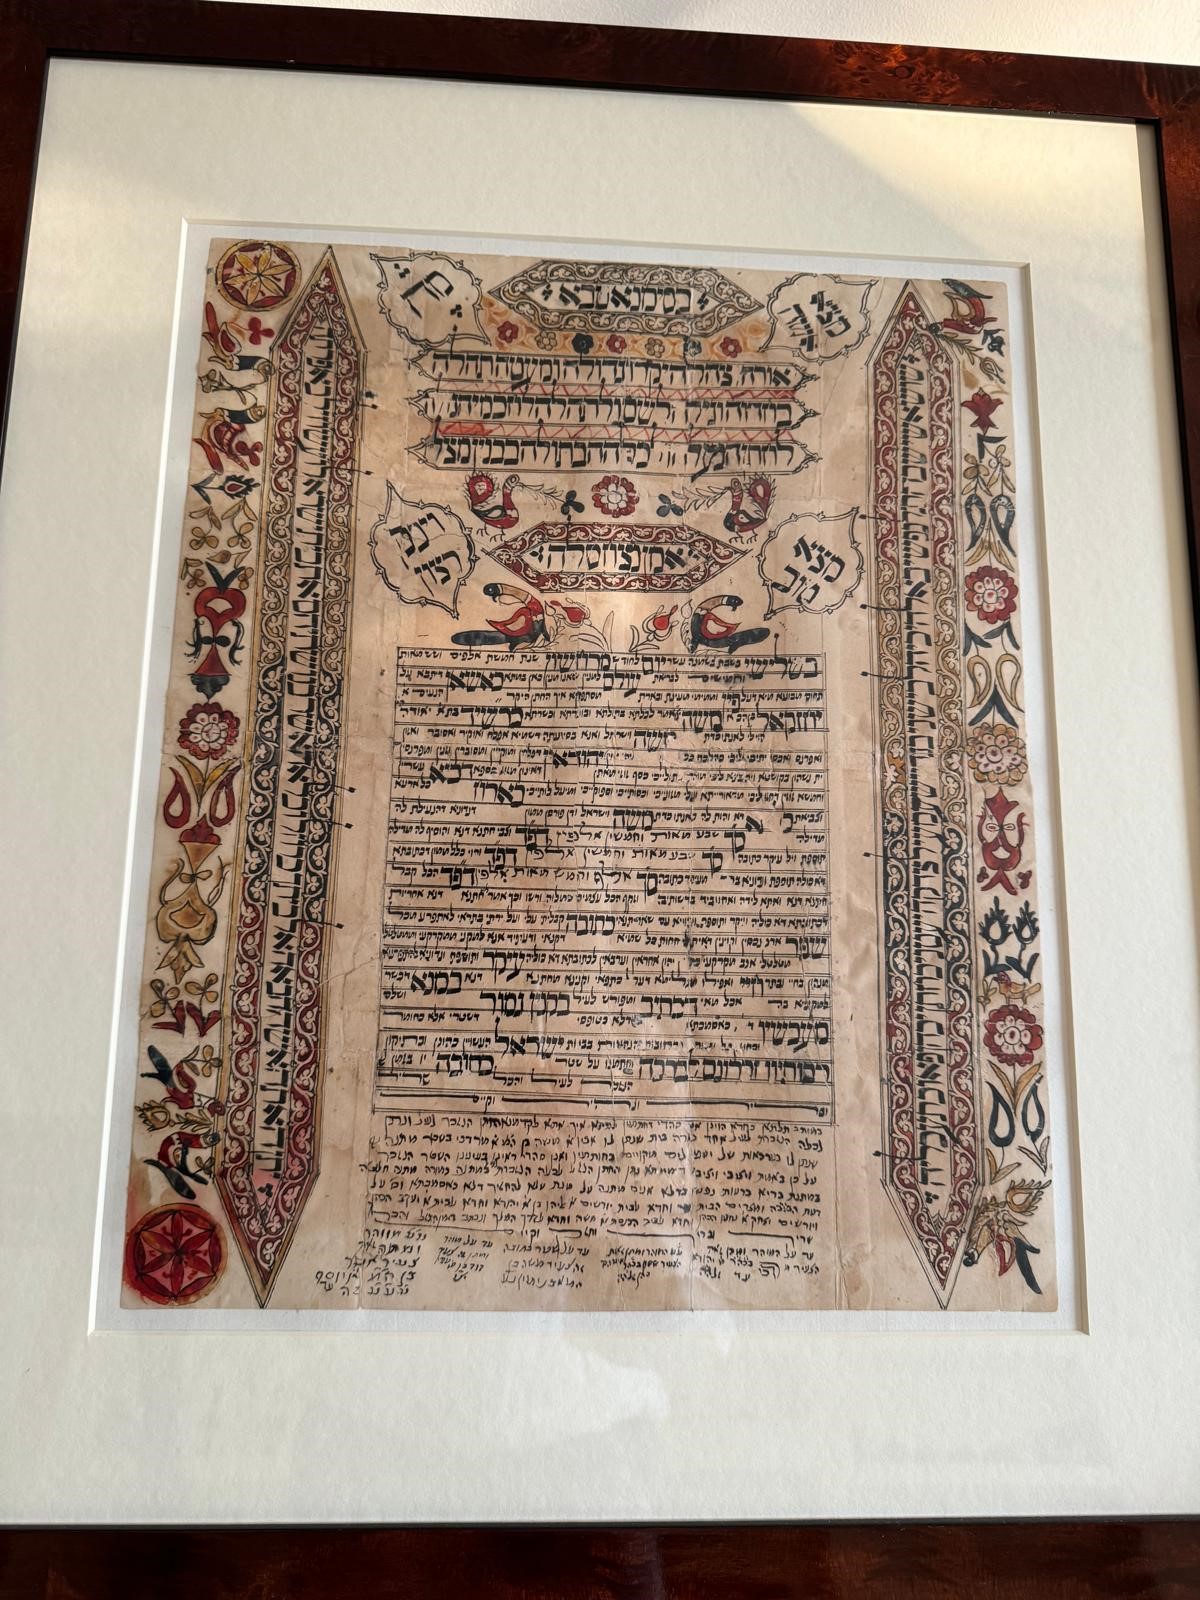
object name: illustrated single work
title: Ketubah (Jewish Marriage Certificate)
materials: glaze, ink, paper, watercolor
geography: iran